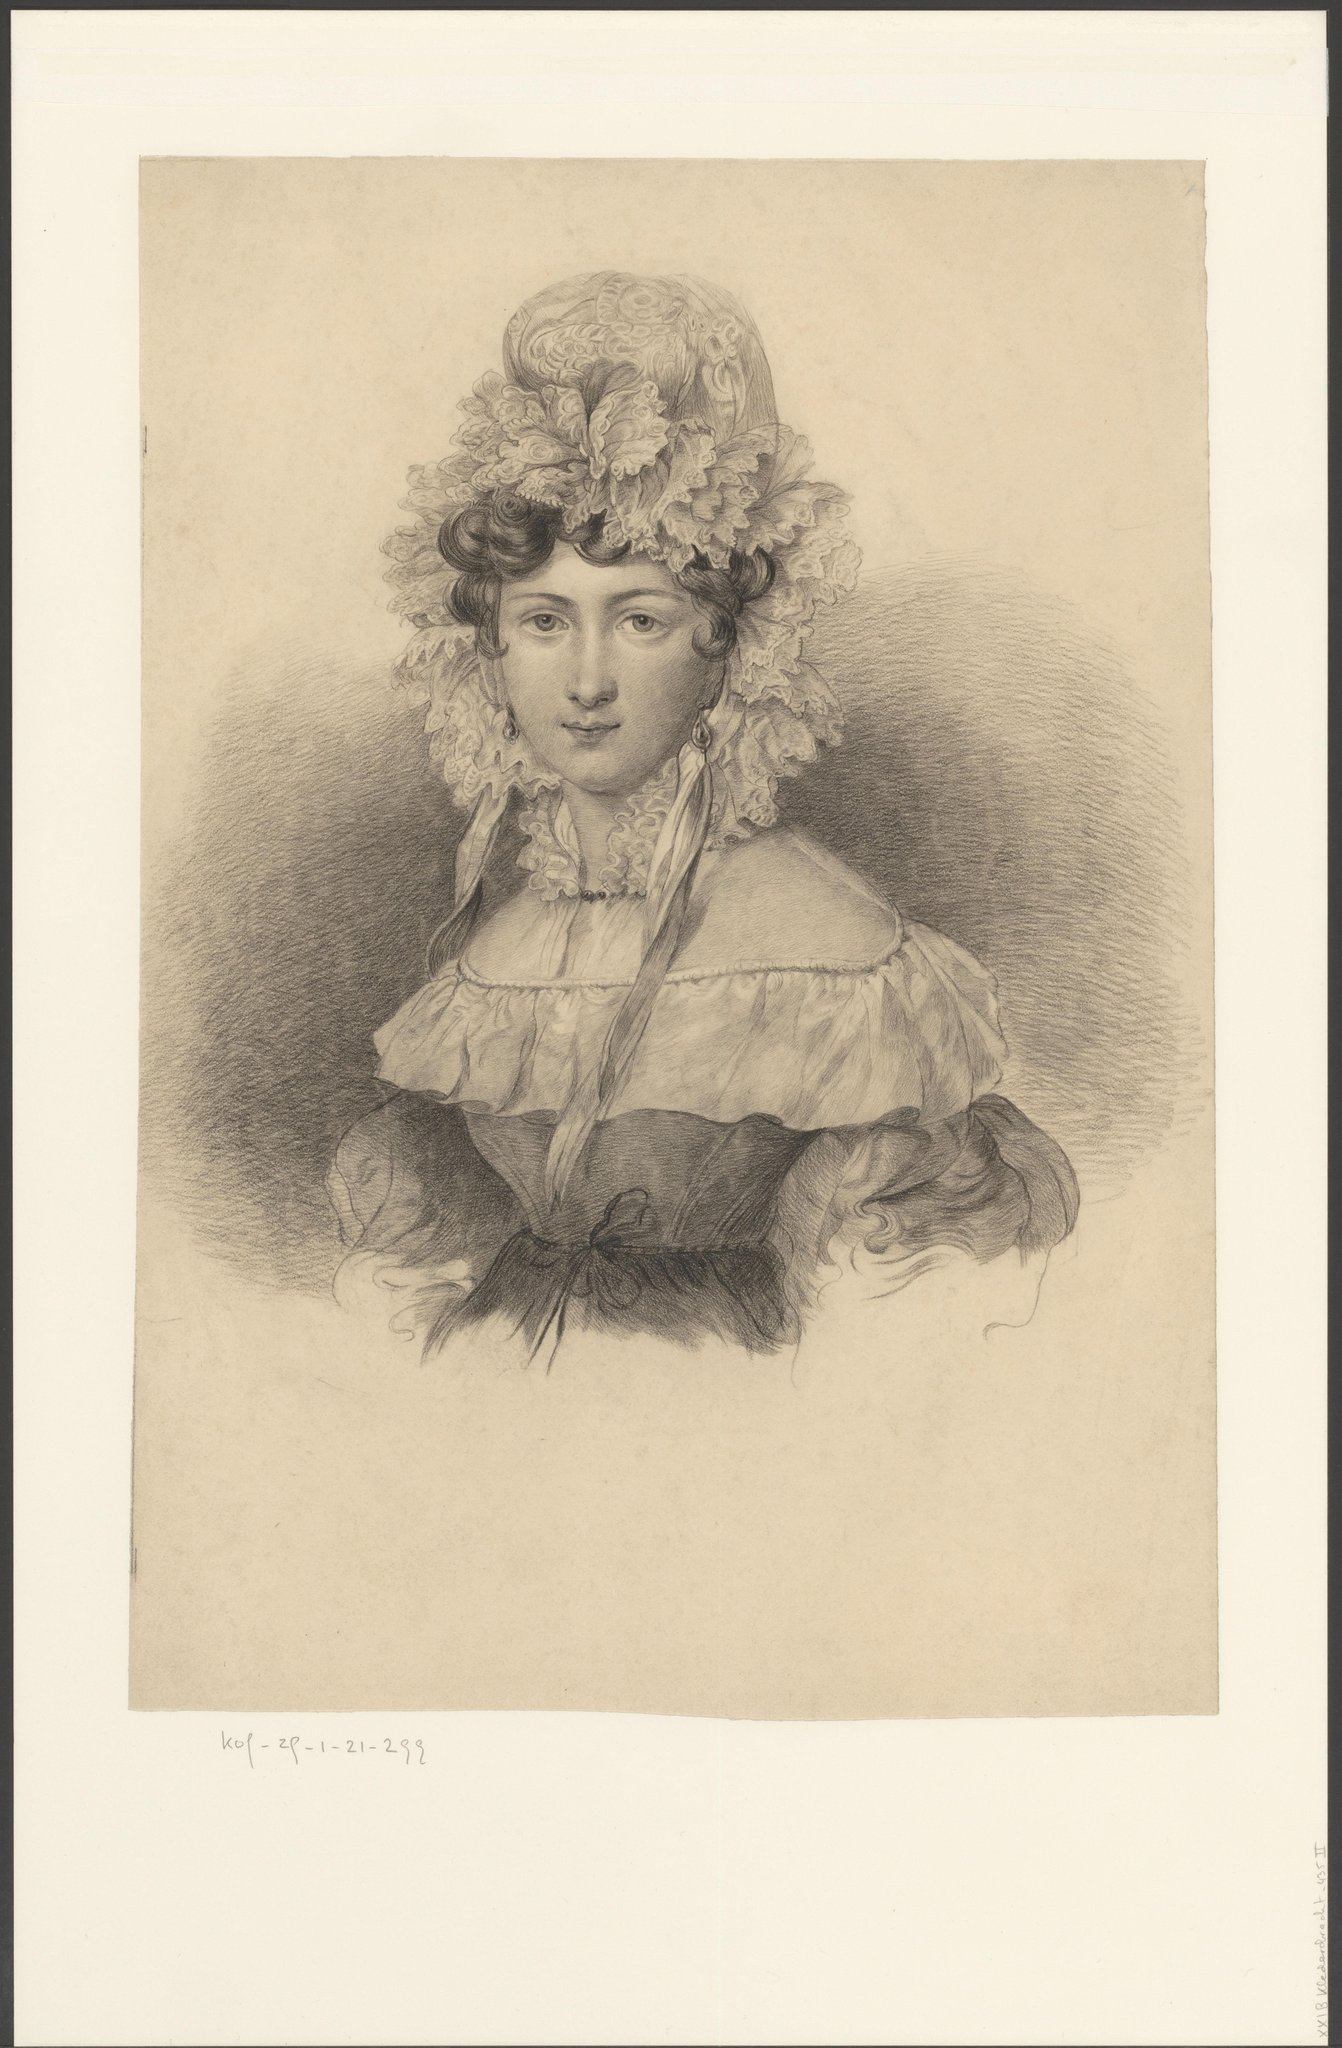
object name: drawing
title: Dame met muts met rushes en linten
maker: Anonymous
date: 1850-1870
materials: chalk, paper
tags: head-gear: cap, dress, gown, clothes, costume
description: Onderwerpsrubrieken binnen de Atlas Zeden en Gewoonten: Zeden en Gewoonten in Engeren Zin, De Kleeding, Kleederdrachten (tijdvakken), De crinolinetijd.